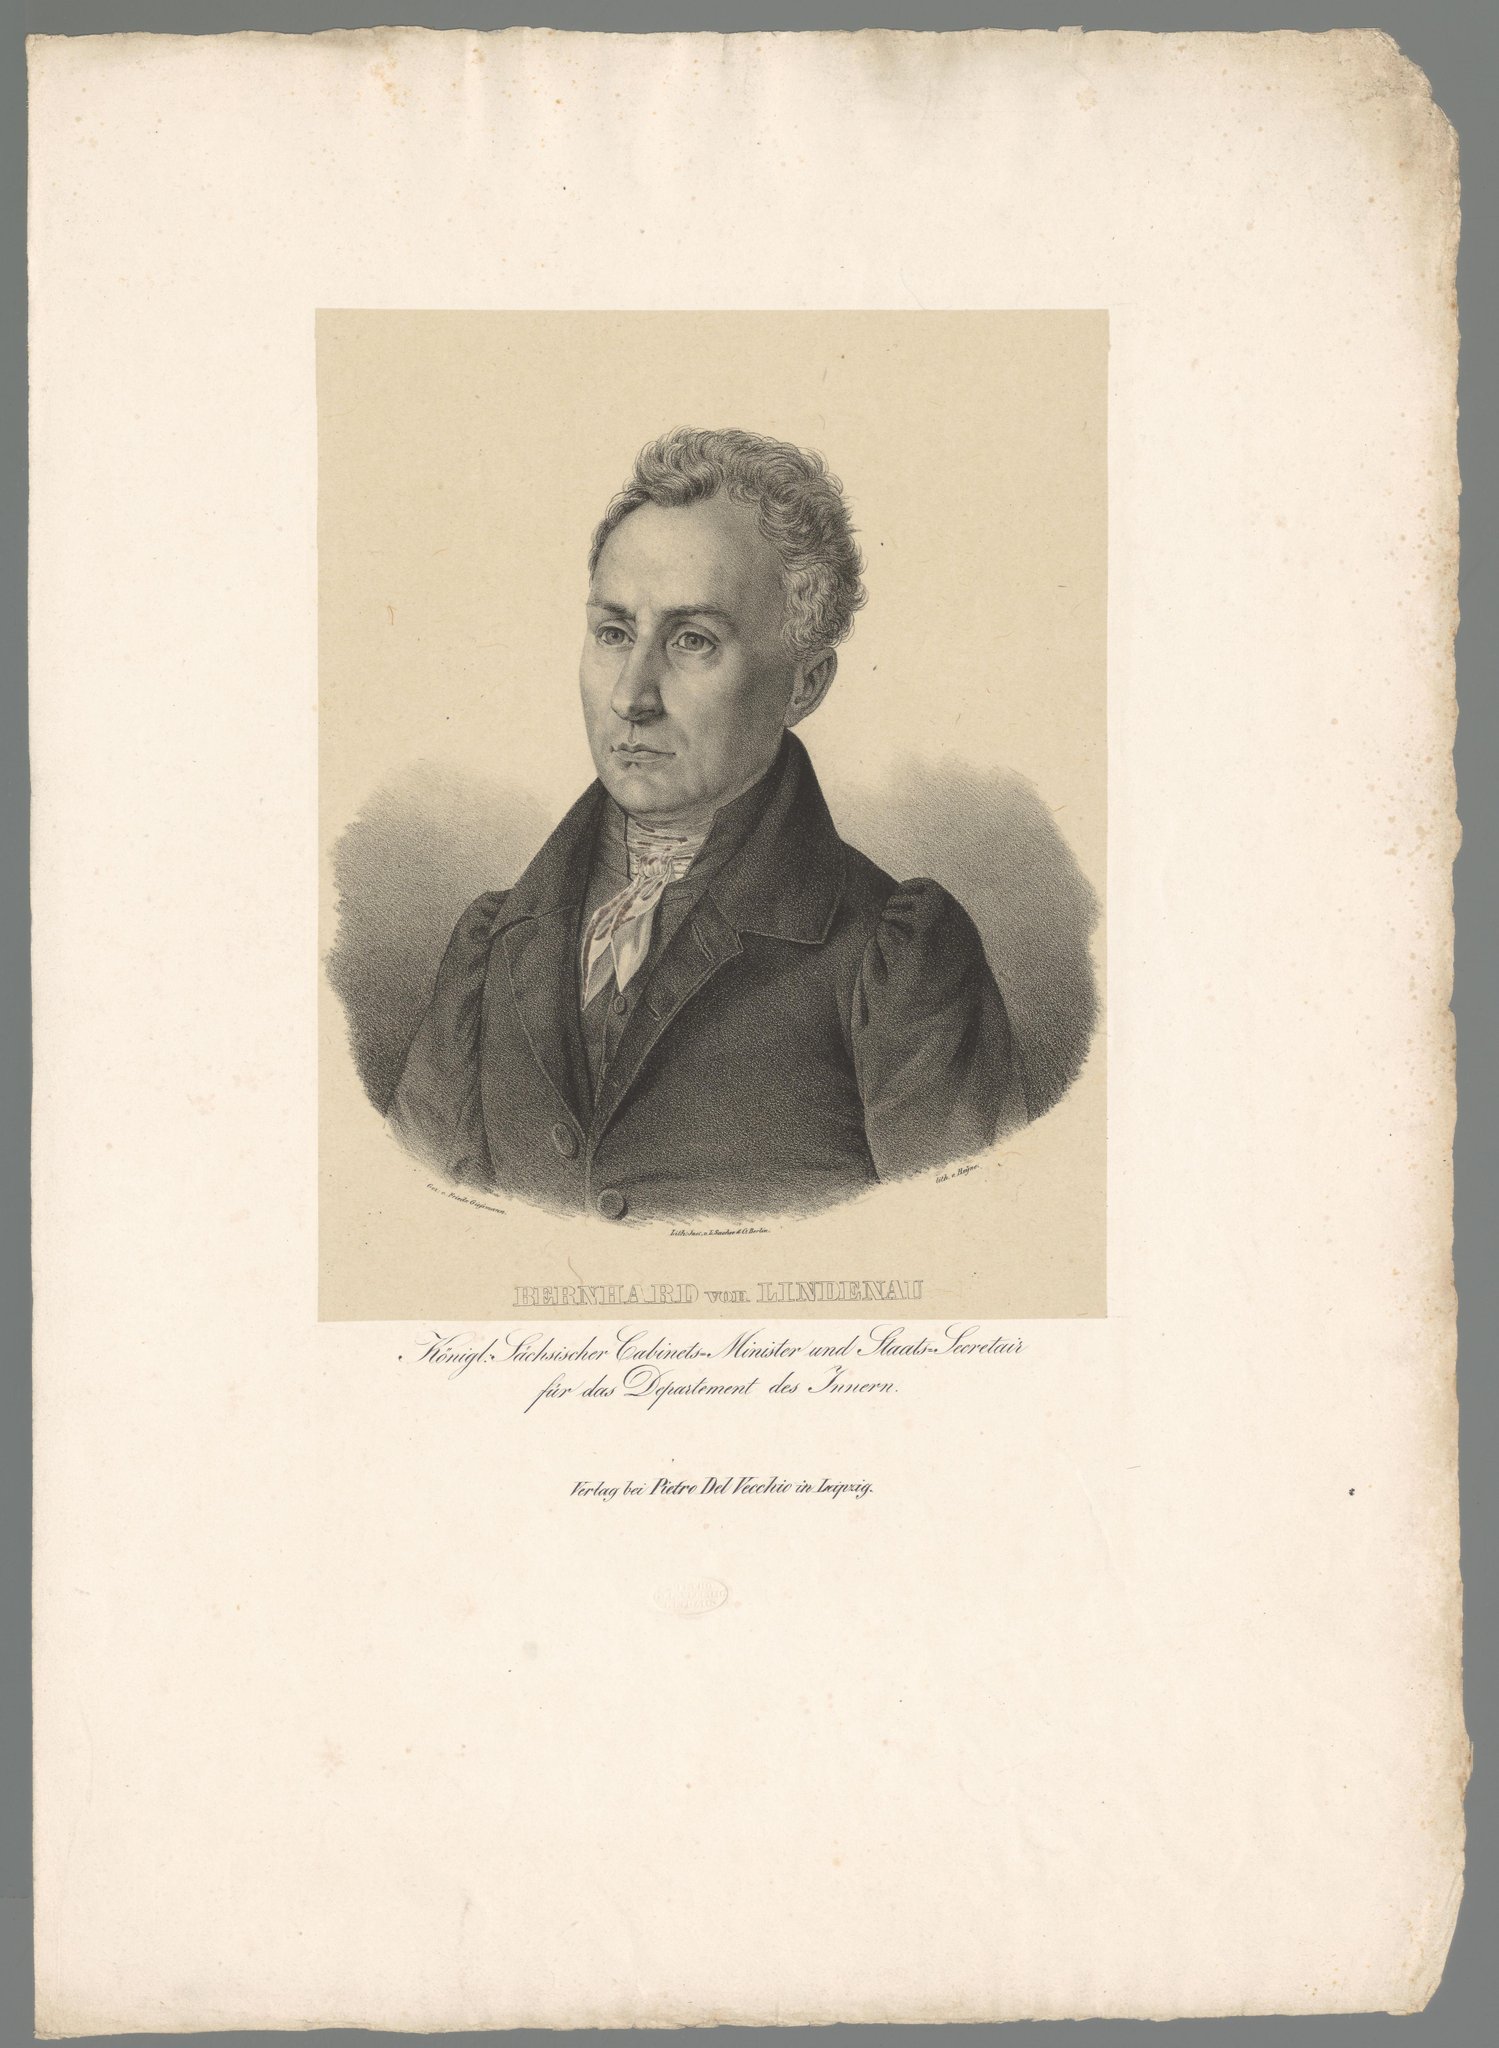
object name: print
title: Portret van Bernhard von Lindenau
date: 1832-1847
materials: paper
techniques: lithograph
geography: berlin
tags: historical persons, politician, e.g. party leader, law and jurisprudence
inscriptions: collector's mark: Lugt 2228, check stamp: ‘Pietro Del Vecchio Leipzig’